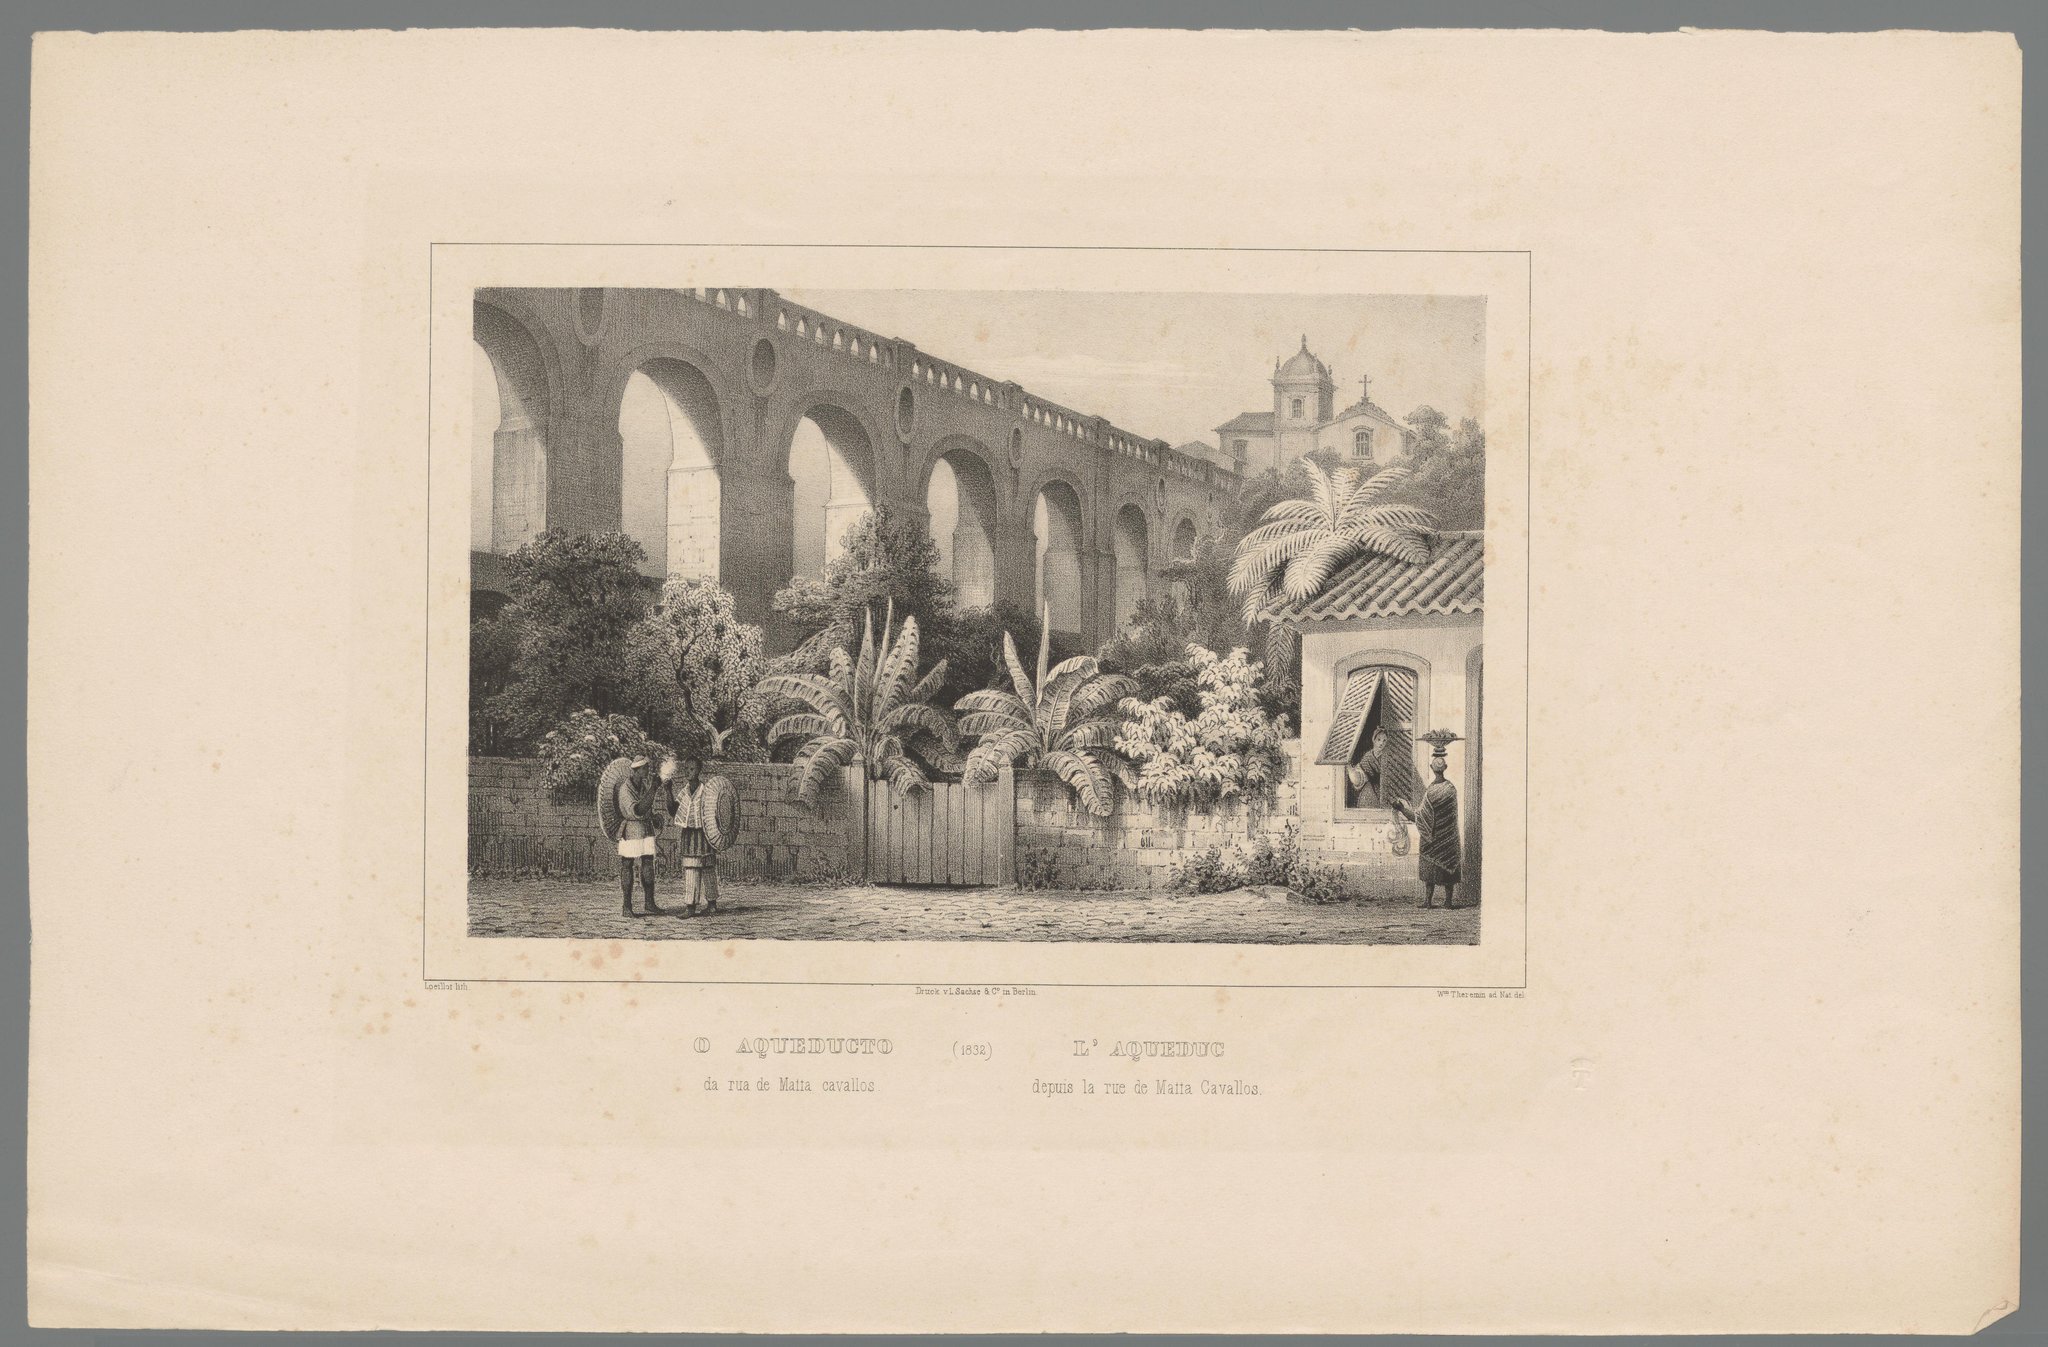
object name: print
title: O Aqueducto / L'Aqueduc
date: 1832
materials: paper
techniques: lithograph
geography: berlin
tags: landscape with bridge, viaduct or aqueduct, aqueduct (~ water supply)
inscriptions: collector's mark: Lugt 2228, check stamp: ‘T’